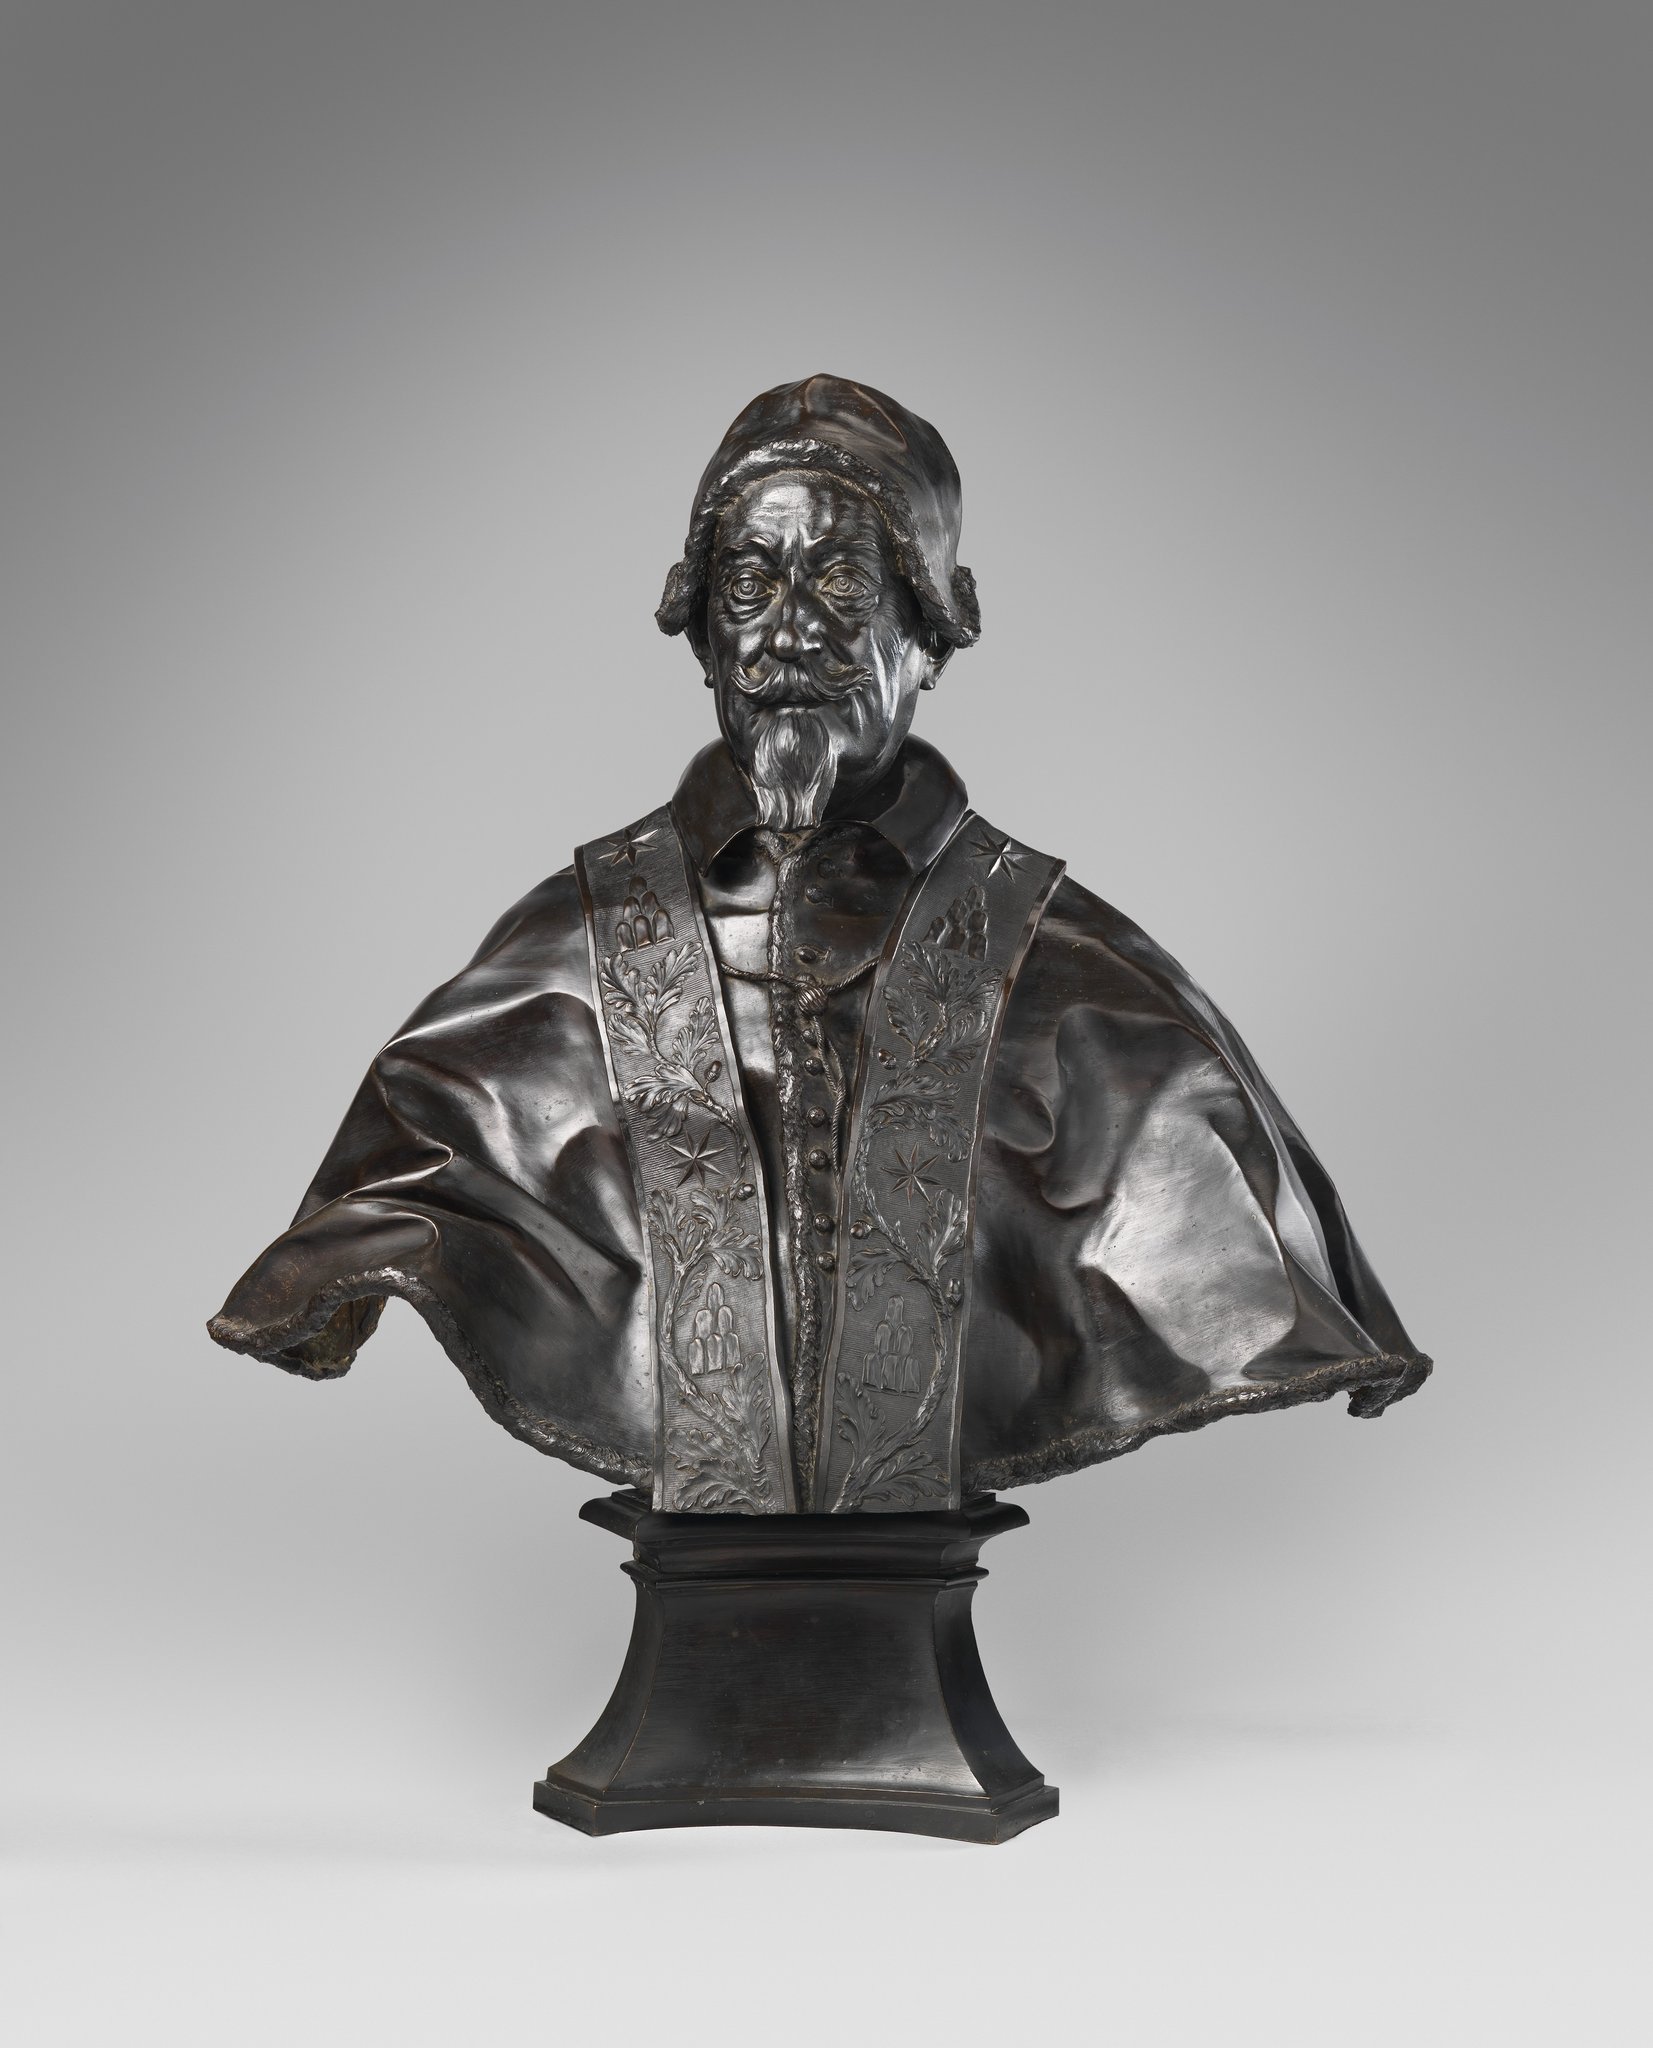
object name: bust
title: Pope Alexander VII (Fabio Chigi, 1599–1667; reigned 1655–67)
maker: melchiorre cafà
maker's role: artist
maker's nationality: maltese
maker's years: 1638-1667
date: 1667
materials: bronze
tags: men,portraits,popes